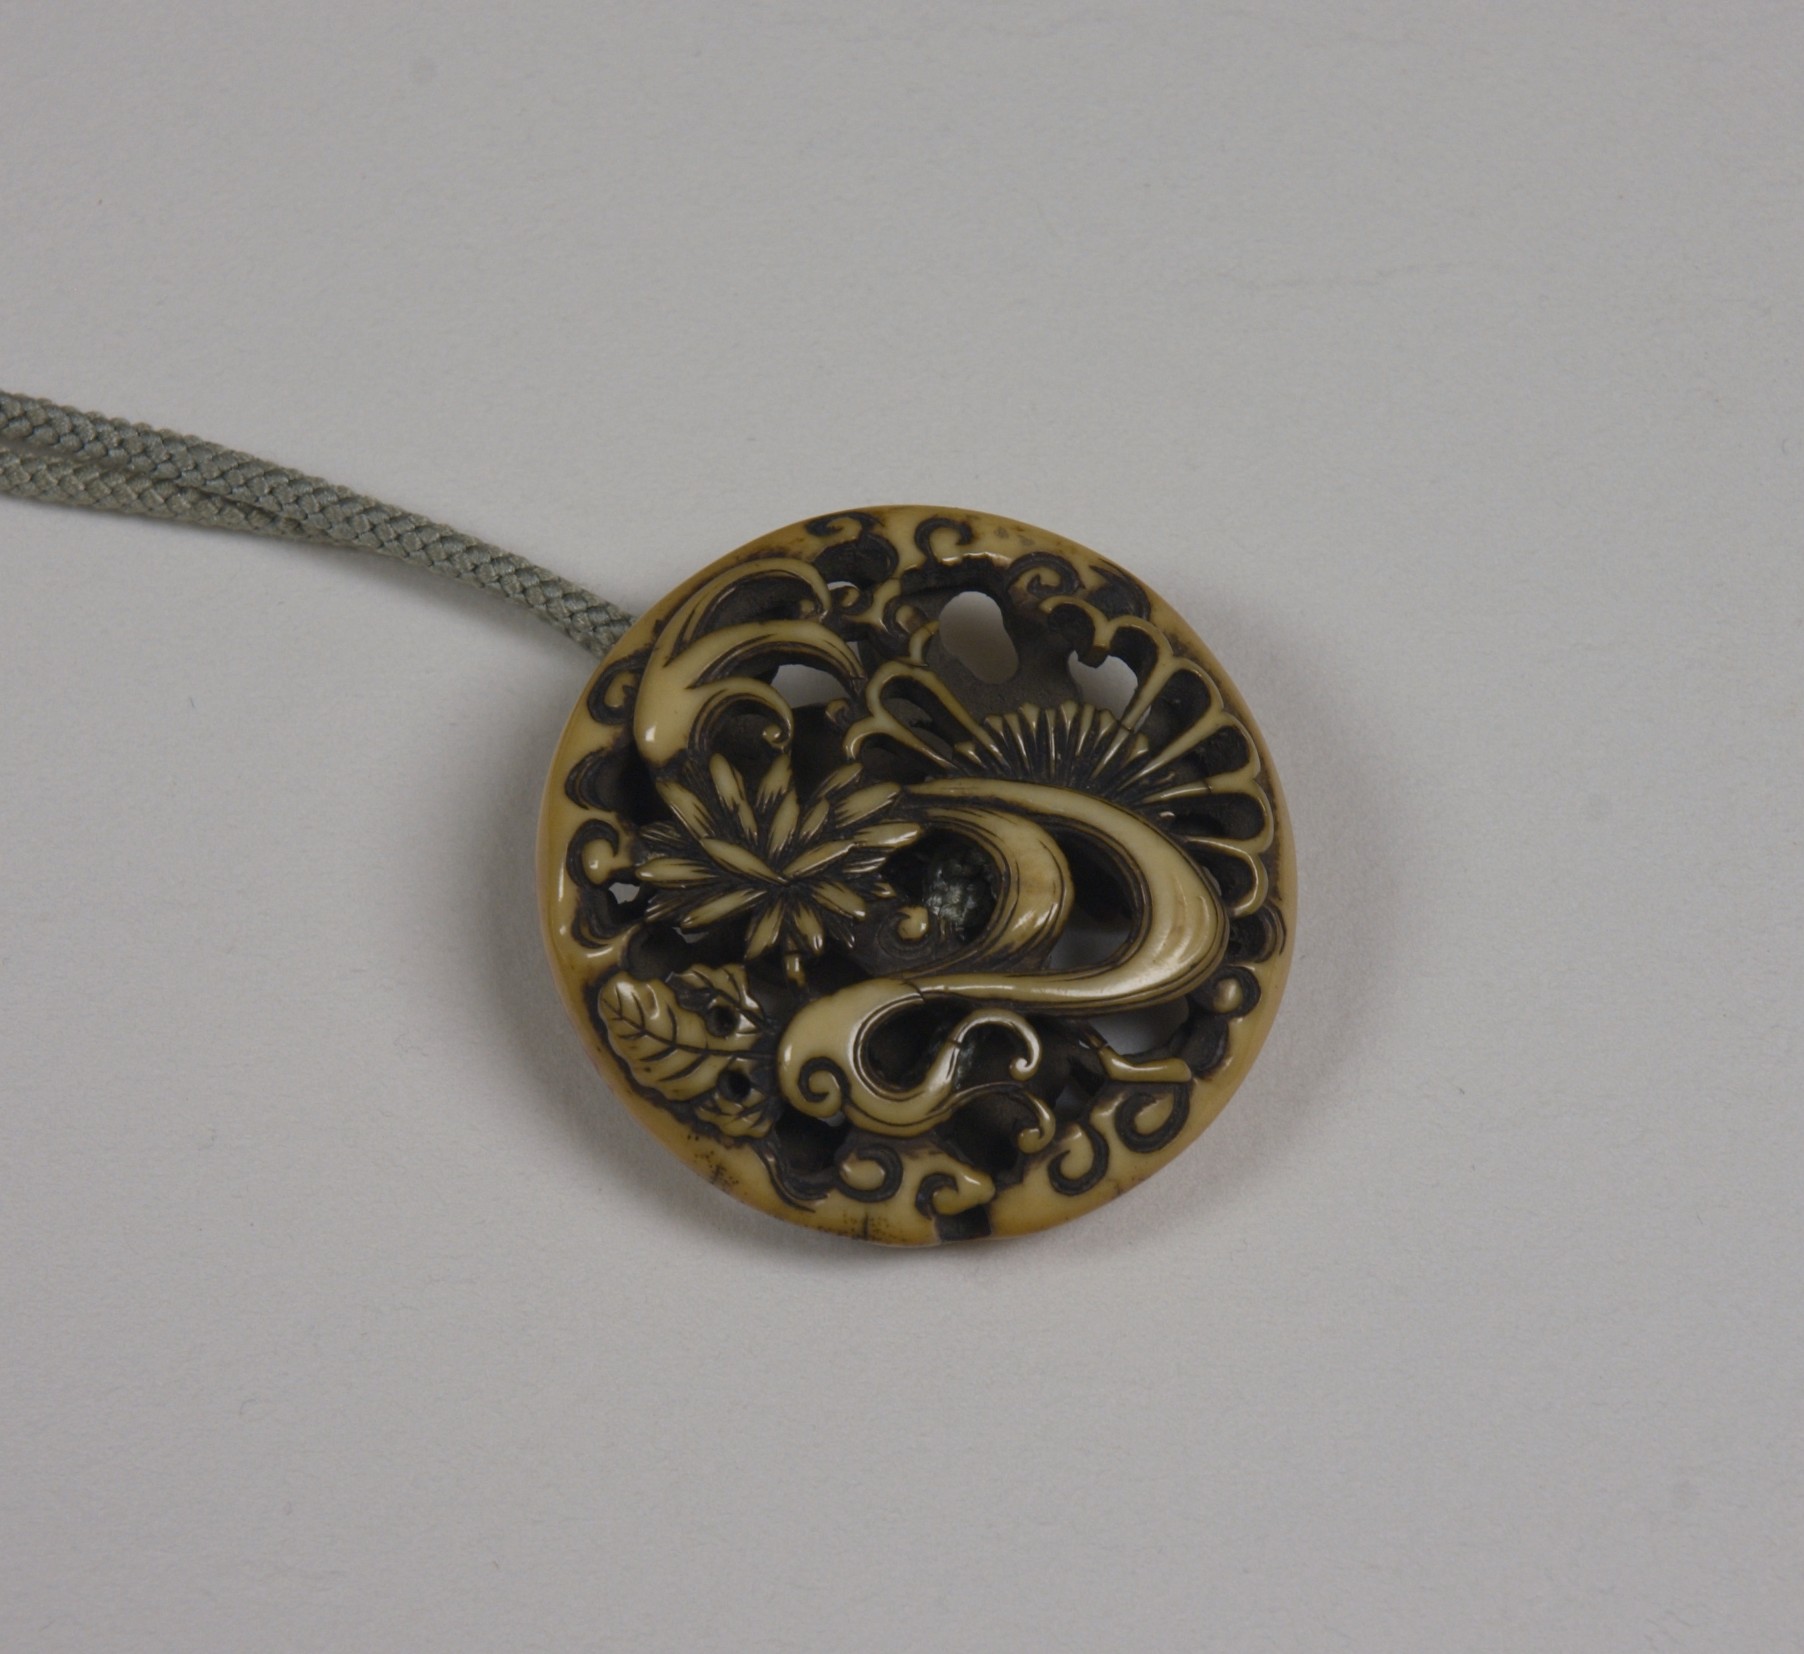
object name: netsuke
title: Netsuke of Chrysanthemum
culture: japanese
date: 1801-1900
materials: ivory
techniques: carving